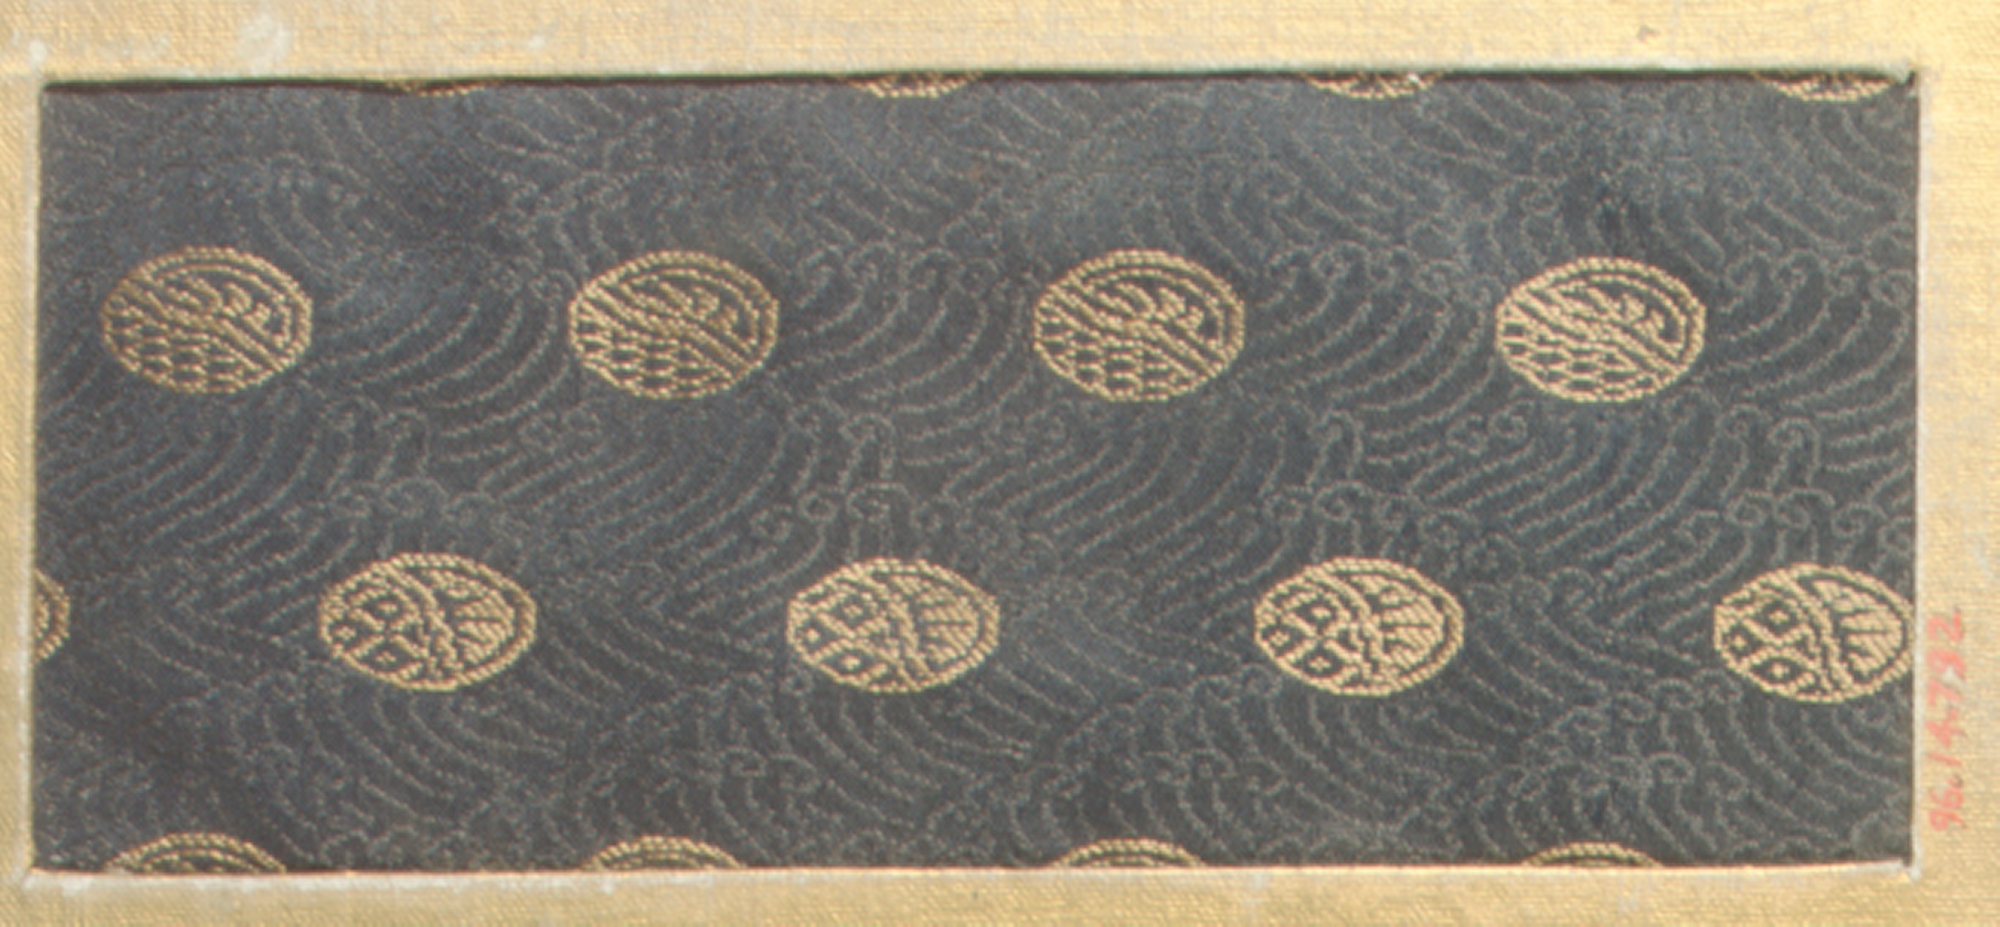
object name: piece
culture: japanese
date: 1701-1900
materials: silk